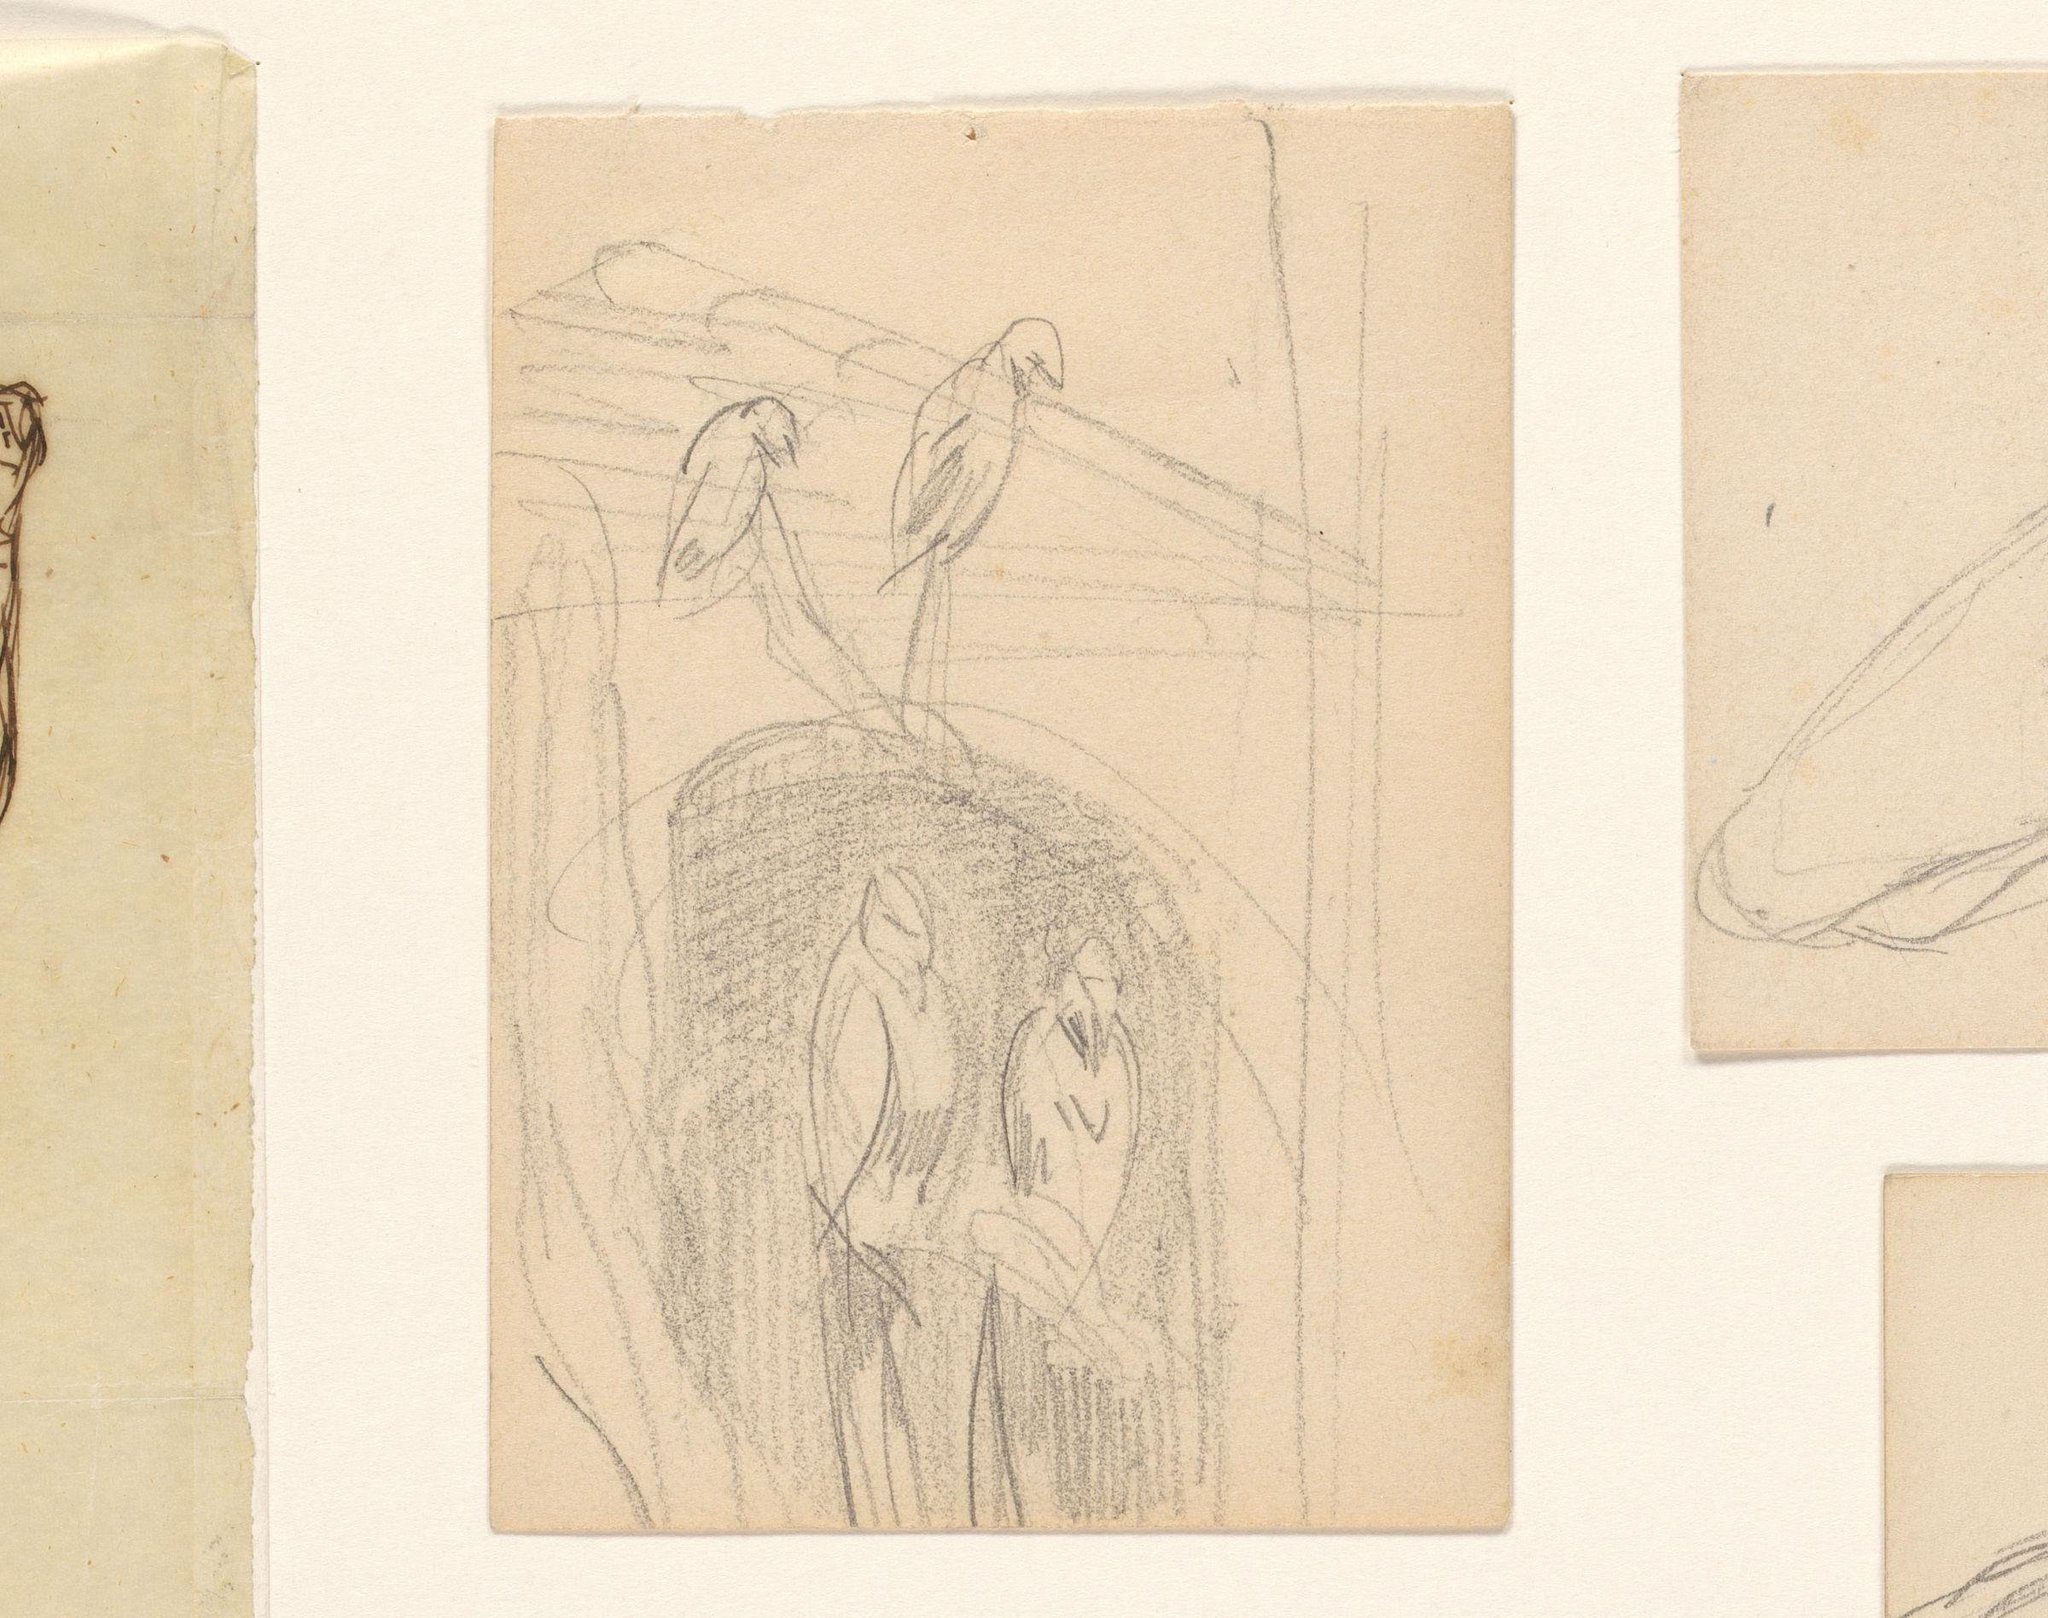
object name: drawing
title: Vogels in een volière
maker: august allebé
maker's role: draughtsman, print maker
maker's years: 1838-1927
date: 1848-1927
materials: paper, pencil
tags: birds in a large cage, aviary